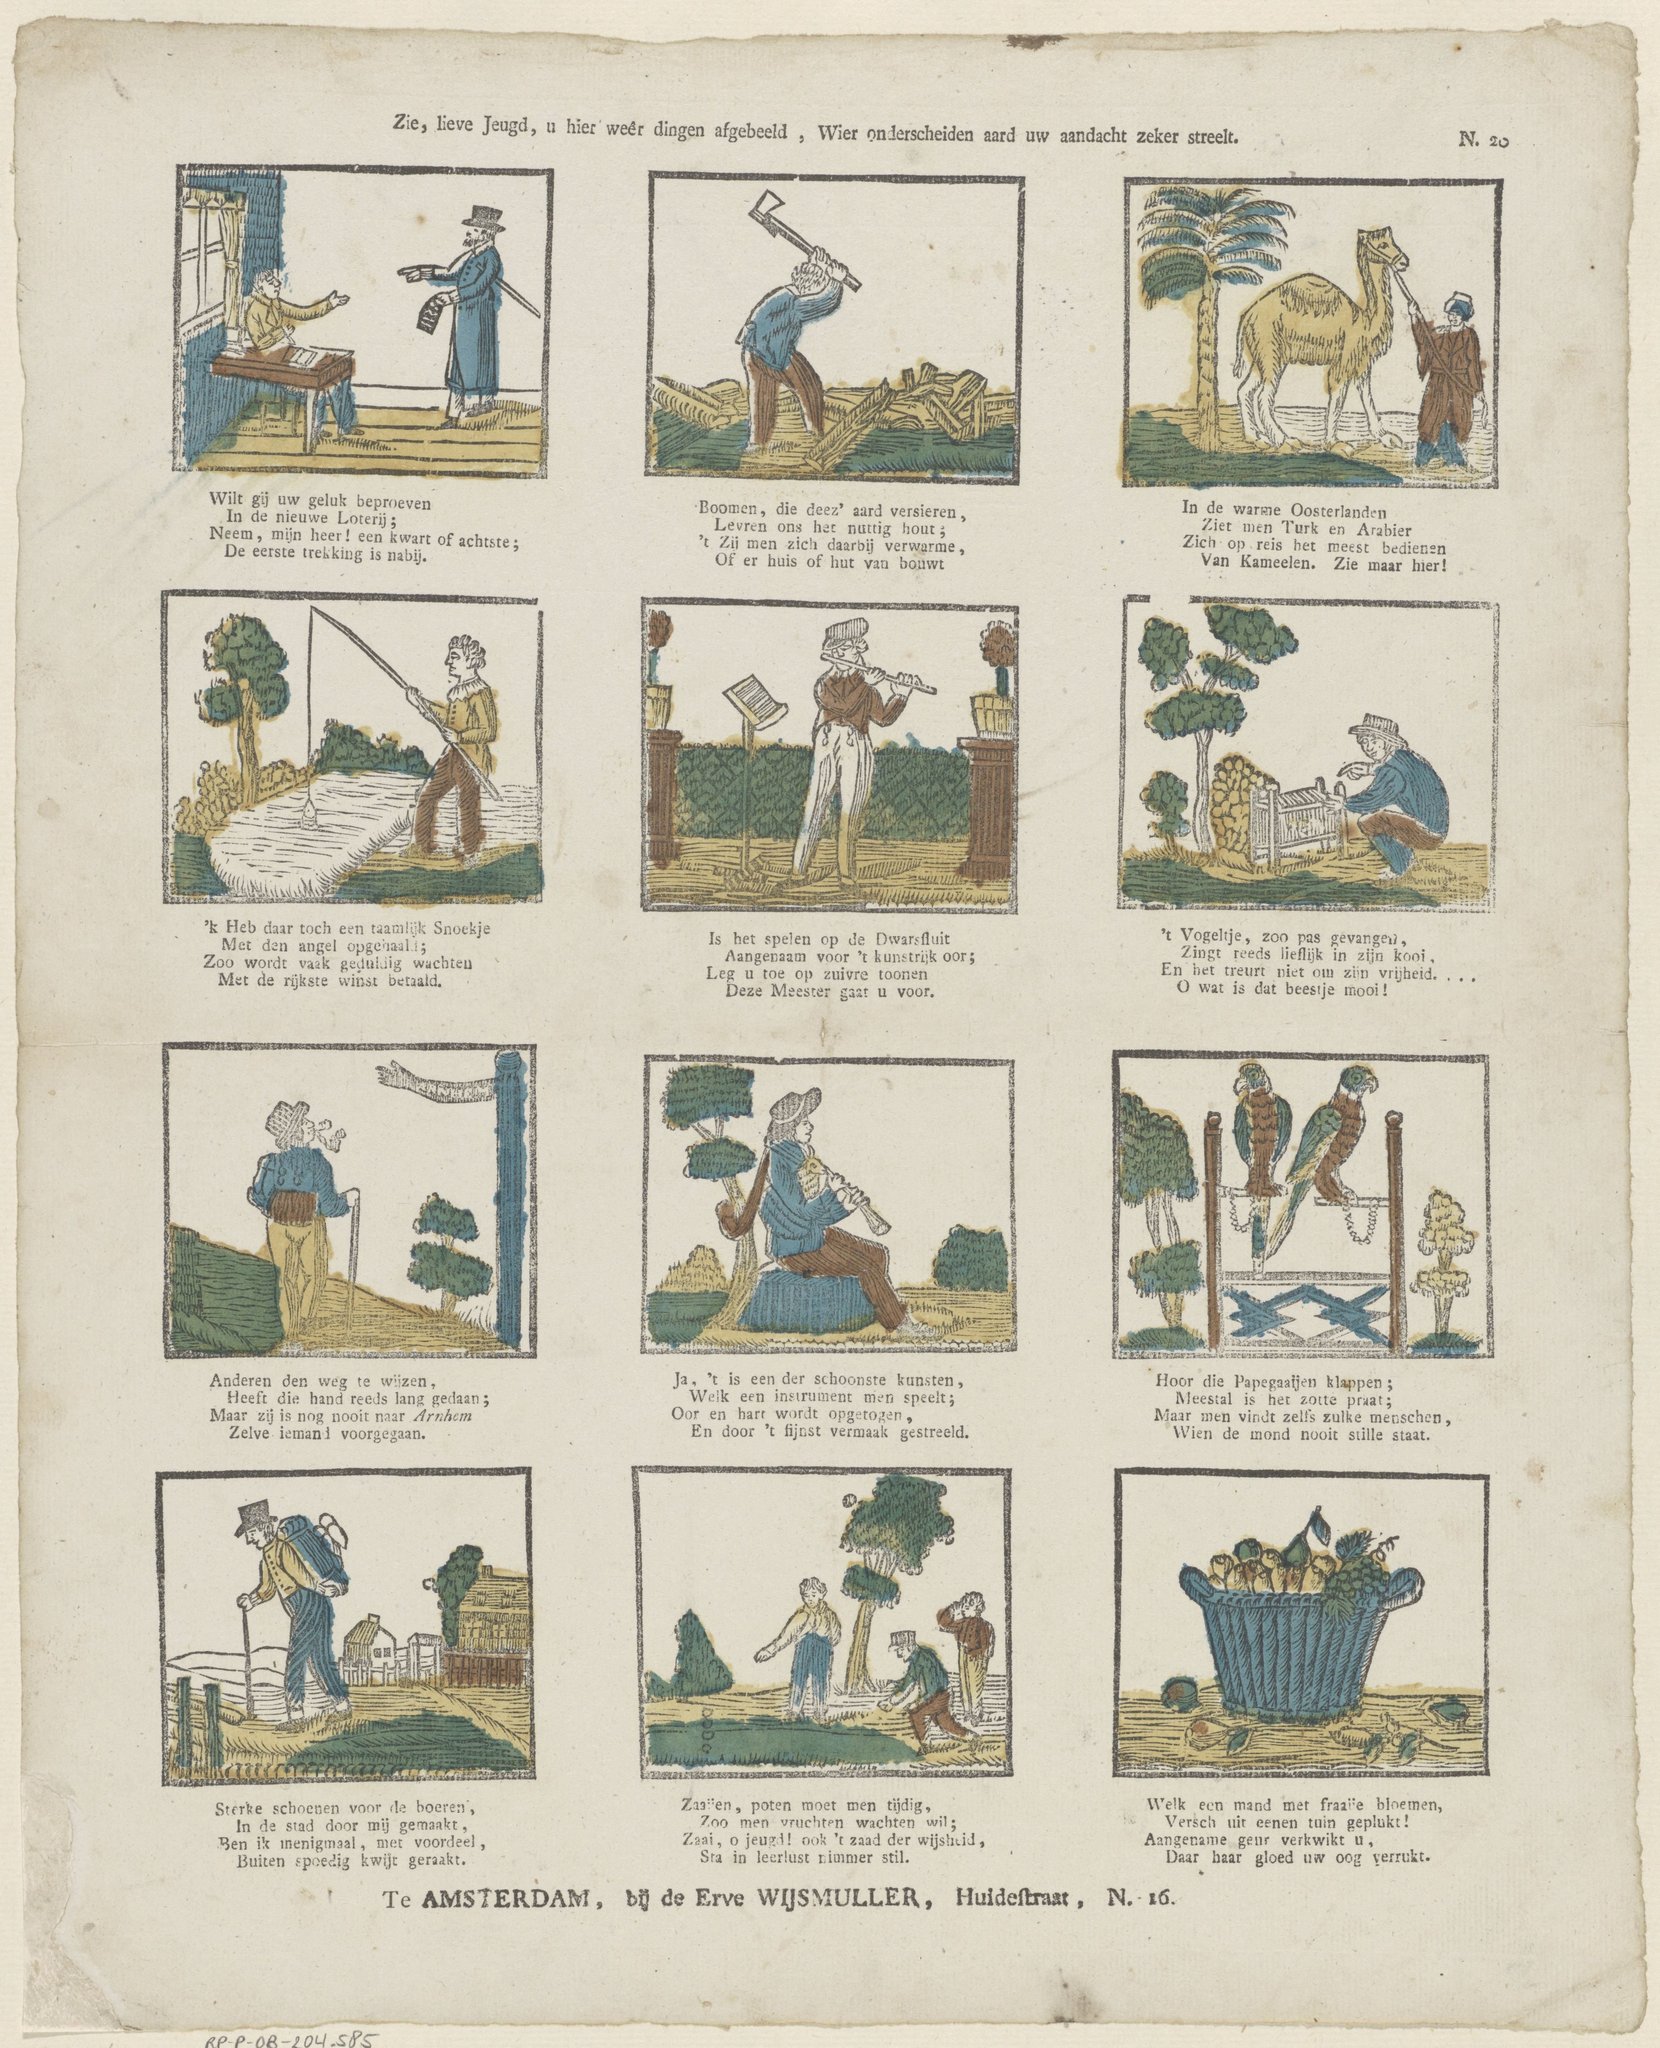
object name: print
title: Zie, lieve jeugd, u hier weêr dingen afgebeeld, / Wier onderscheiden aard uw aandacht zeker streelt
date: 1828-1849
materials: paper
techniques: colour, letterpress printing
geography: deventer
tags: walking, hiking (recreation), hoofed animals: dromedary, animals, human types, ornamental birds: parrot, fishing (sports), arnhem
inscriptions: collector's mark: Lugt 2760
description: Blad met 12 voorstellingen van figuren, dieren en voorwerpen. Onder elke afbeelding een vierregelig vers. Genummerd rechtsboven: N. 20.